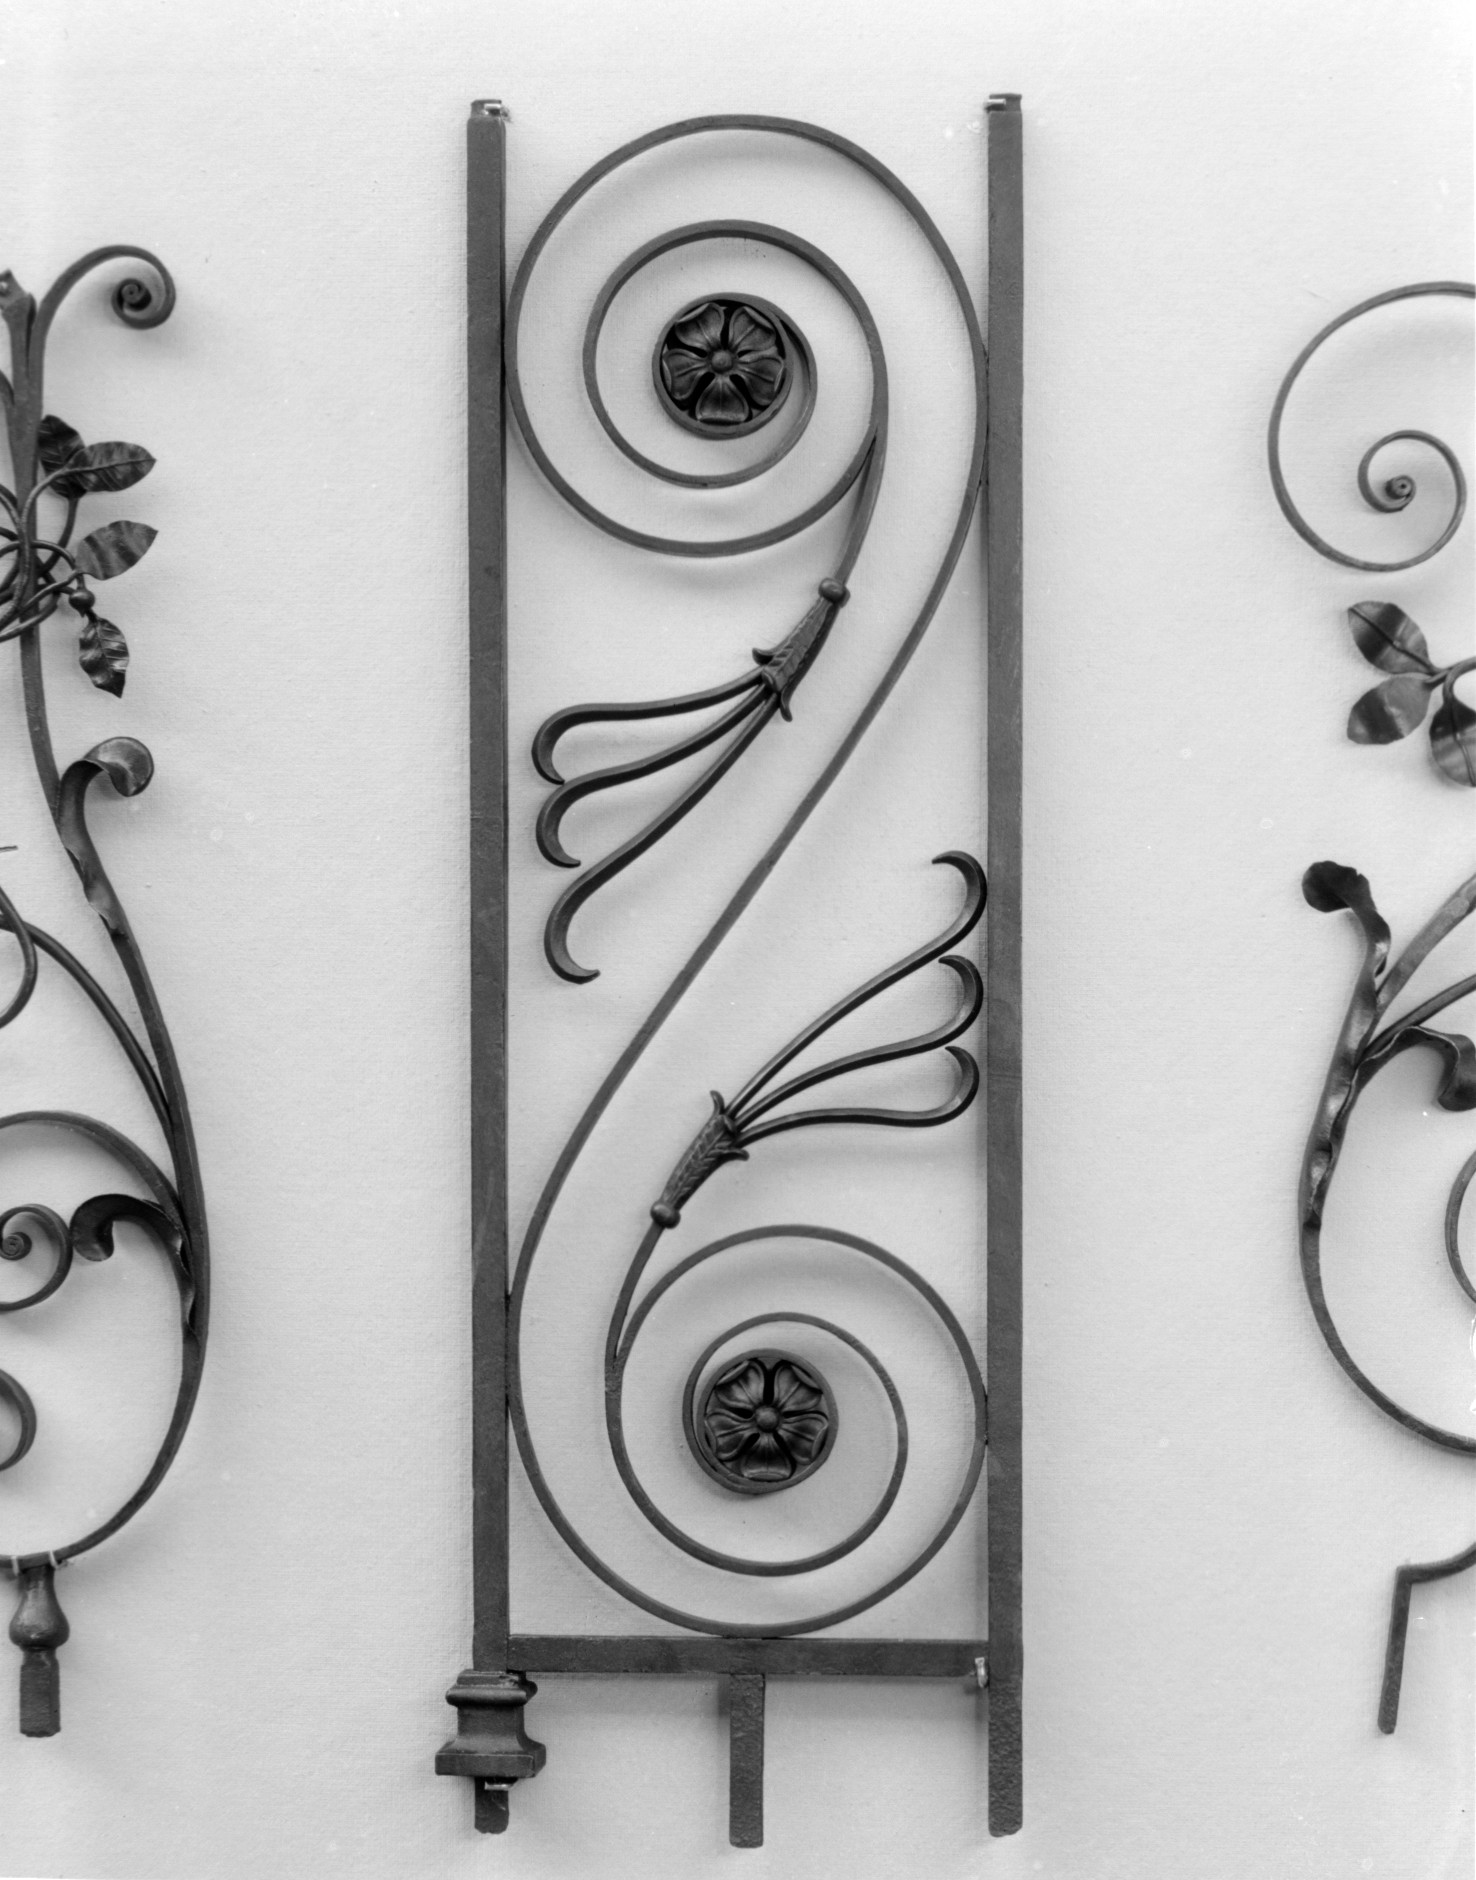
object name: baluster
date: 1790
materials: brass, iron